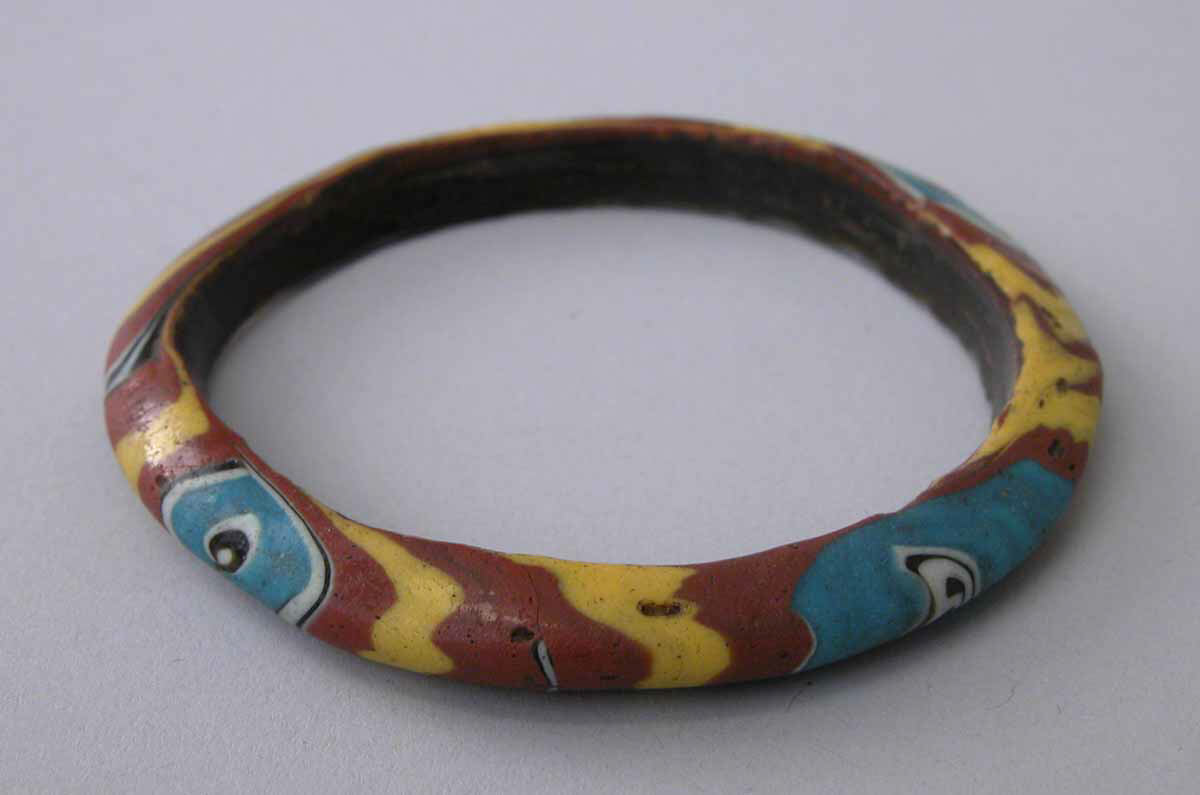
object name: bracelet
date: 1301-1500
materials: glass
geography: egypt or syria